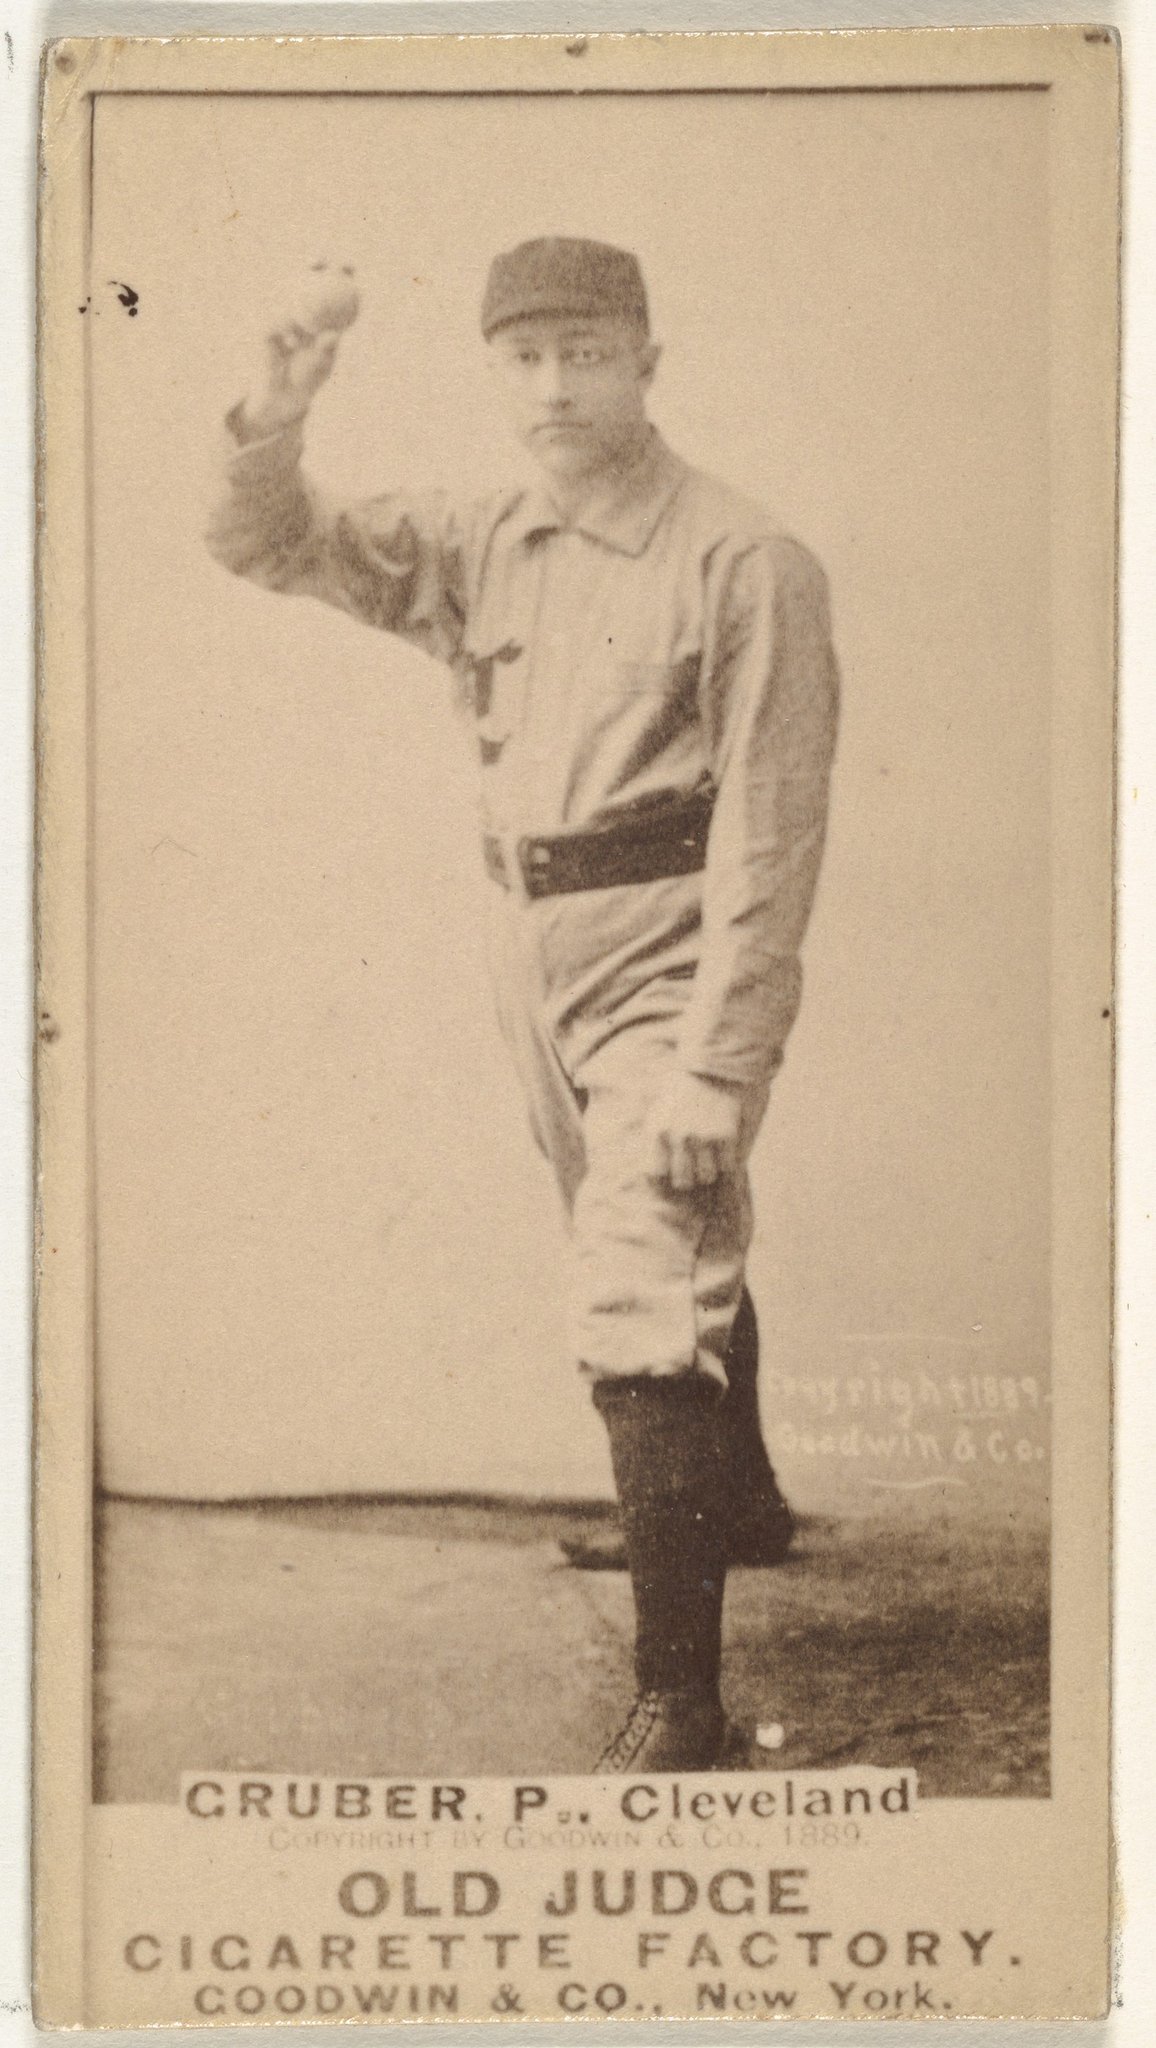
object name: baseball card, photograph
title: Henry Gruber, Pitcher, Cleveland, from the Old Judge series (N172) for Old Judge Cigarettes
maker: goodwin & company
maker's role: publisher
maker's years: 1850-1950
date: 1889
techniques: albumen silver print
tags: men,portraits,baseball,athletes